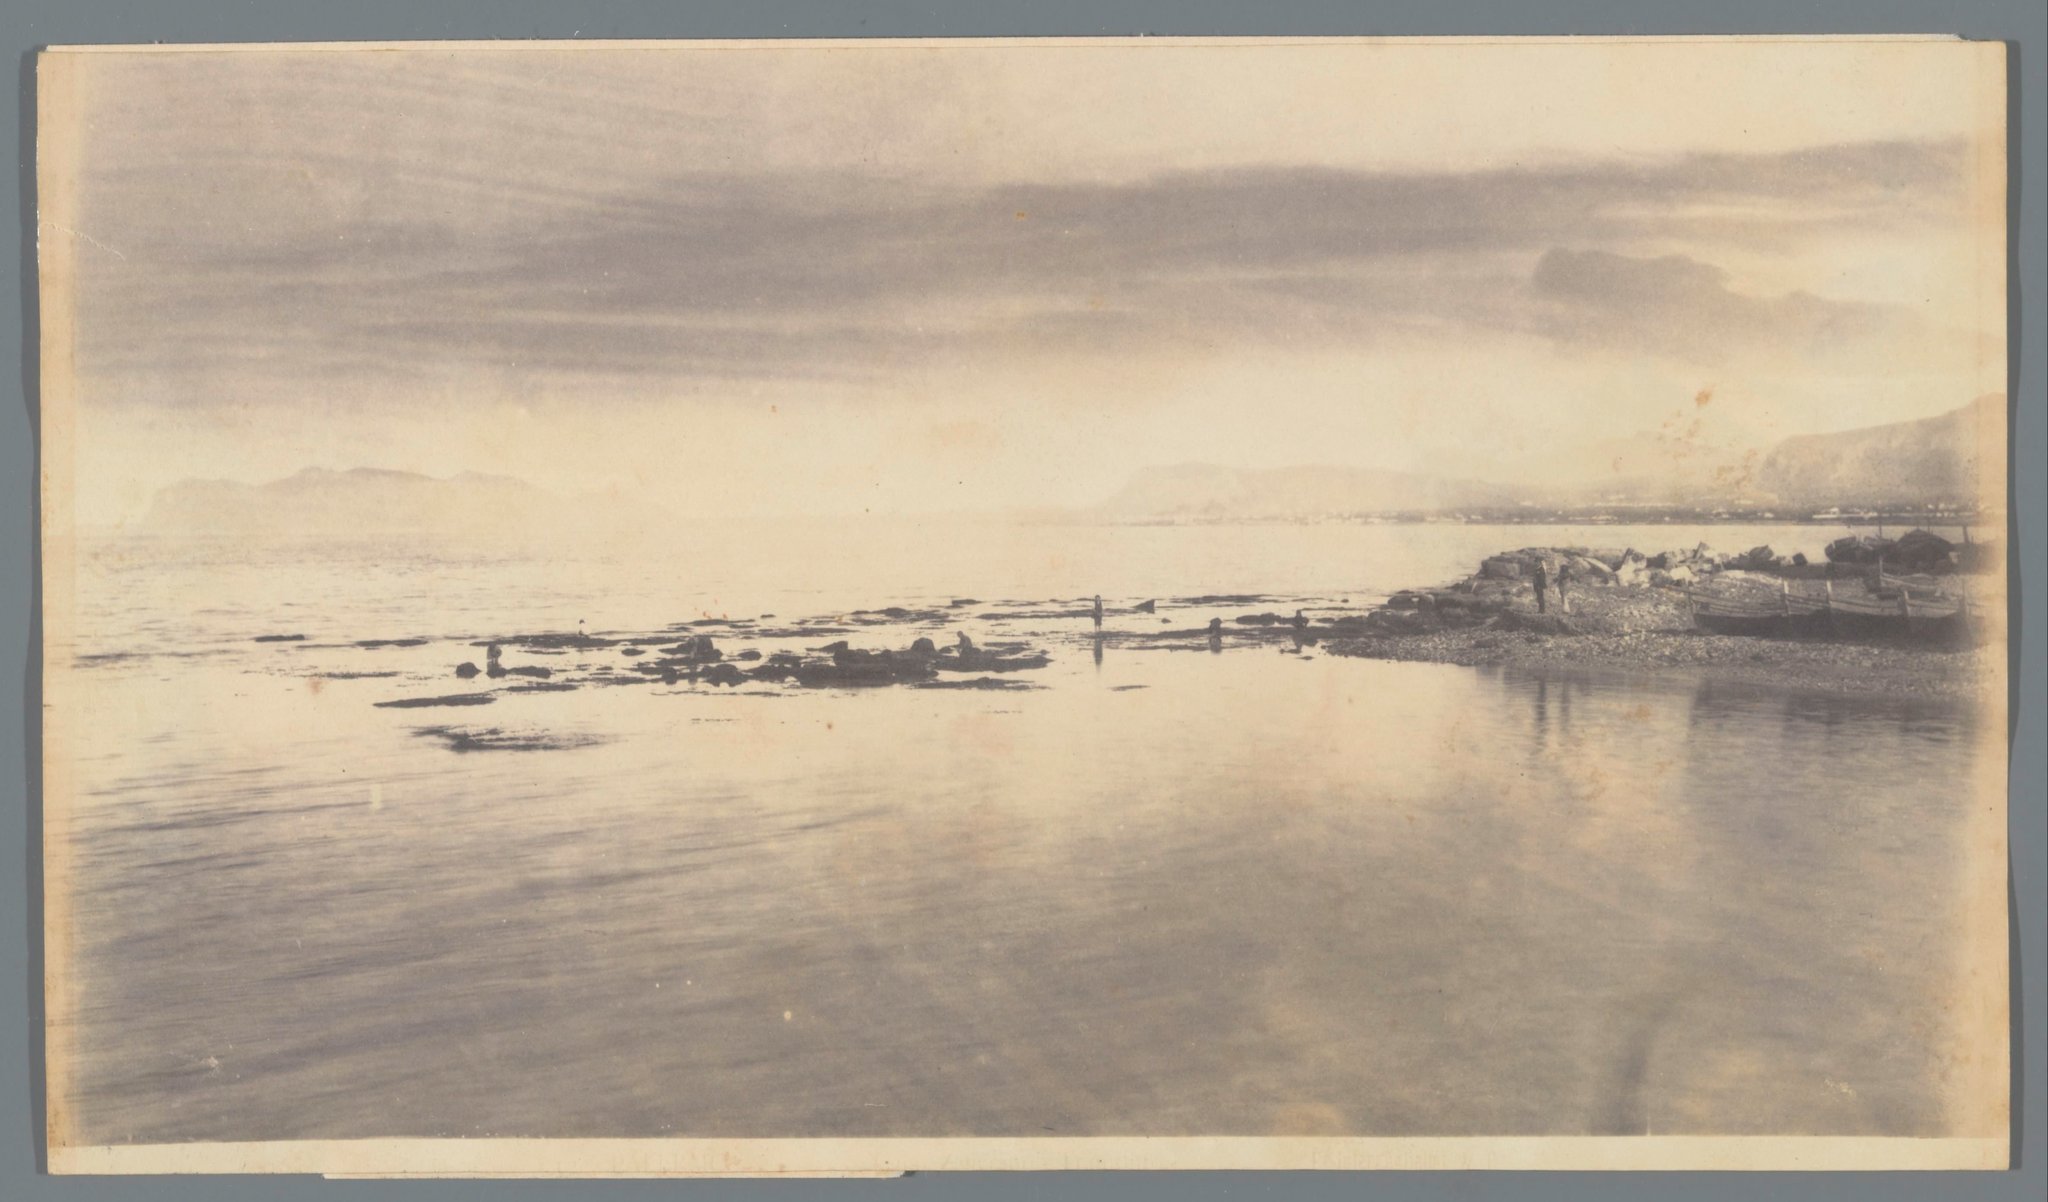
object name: photograph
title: Kustgezicht op Sicilië, rechts enkele vissersboten op het strand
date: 1880-1890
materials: paper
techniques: albumen print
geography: sicily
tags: coast, beach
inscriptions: inscription: ‘Sicilie’, inscription: ‘17 bis’